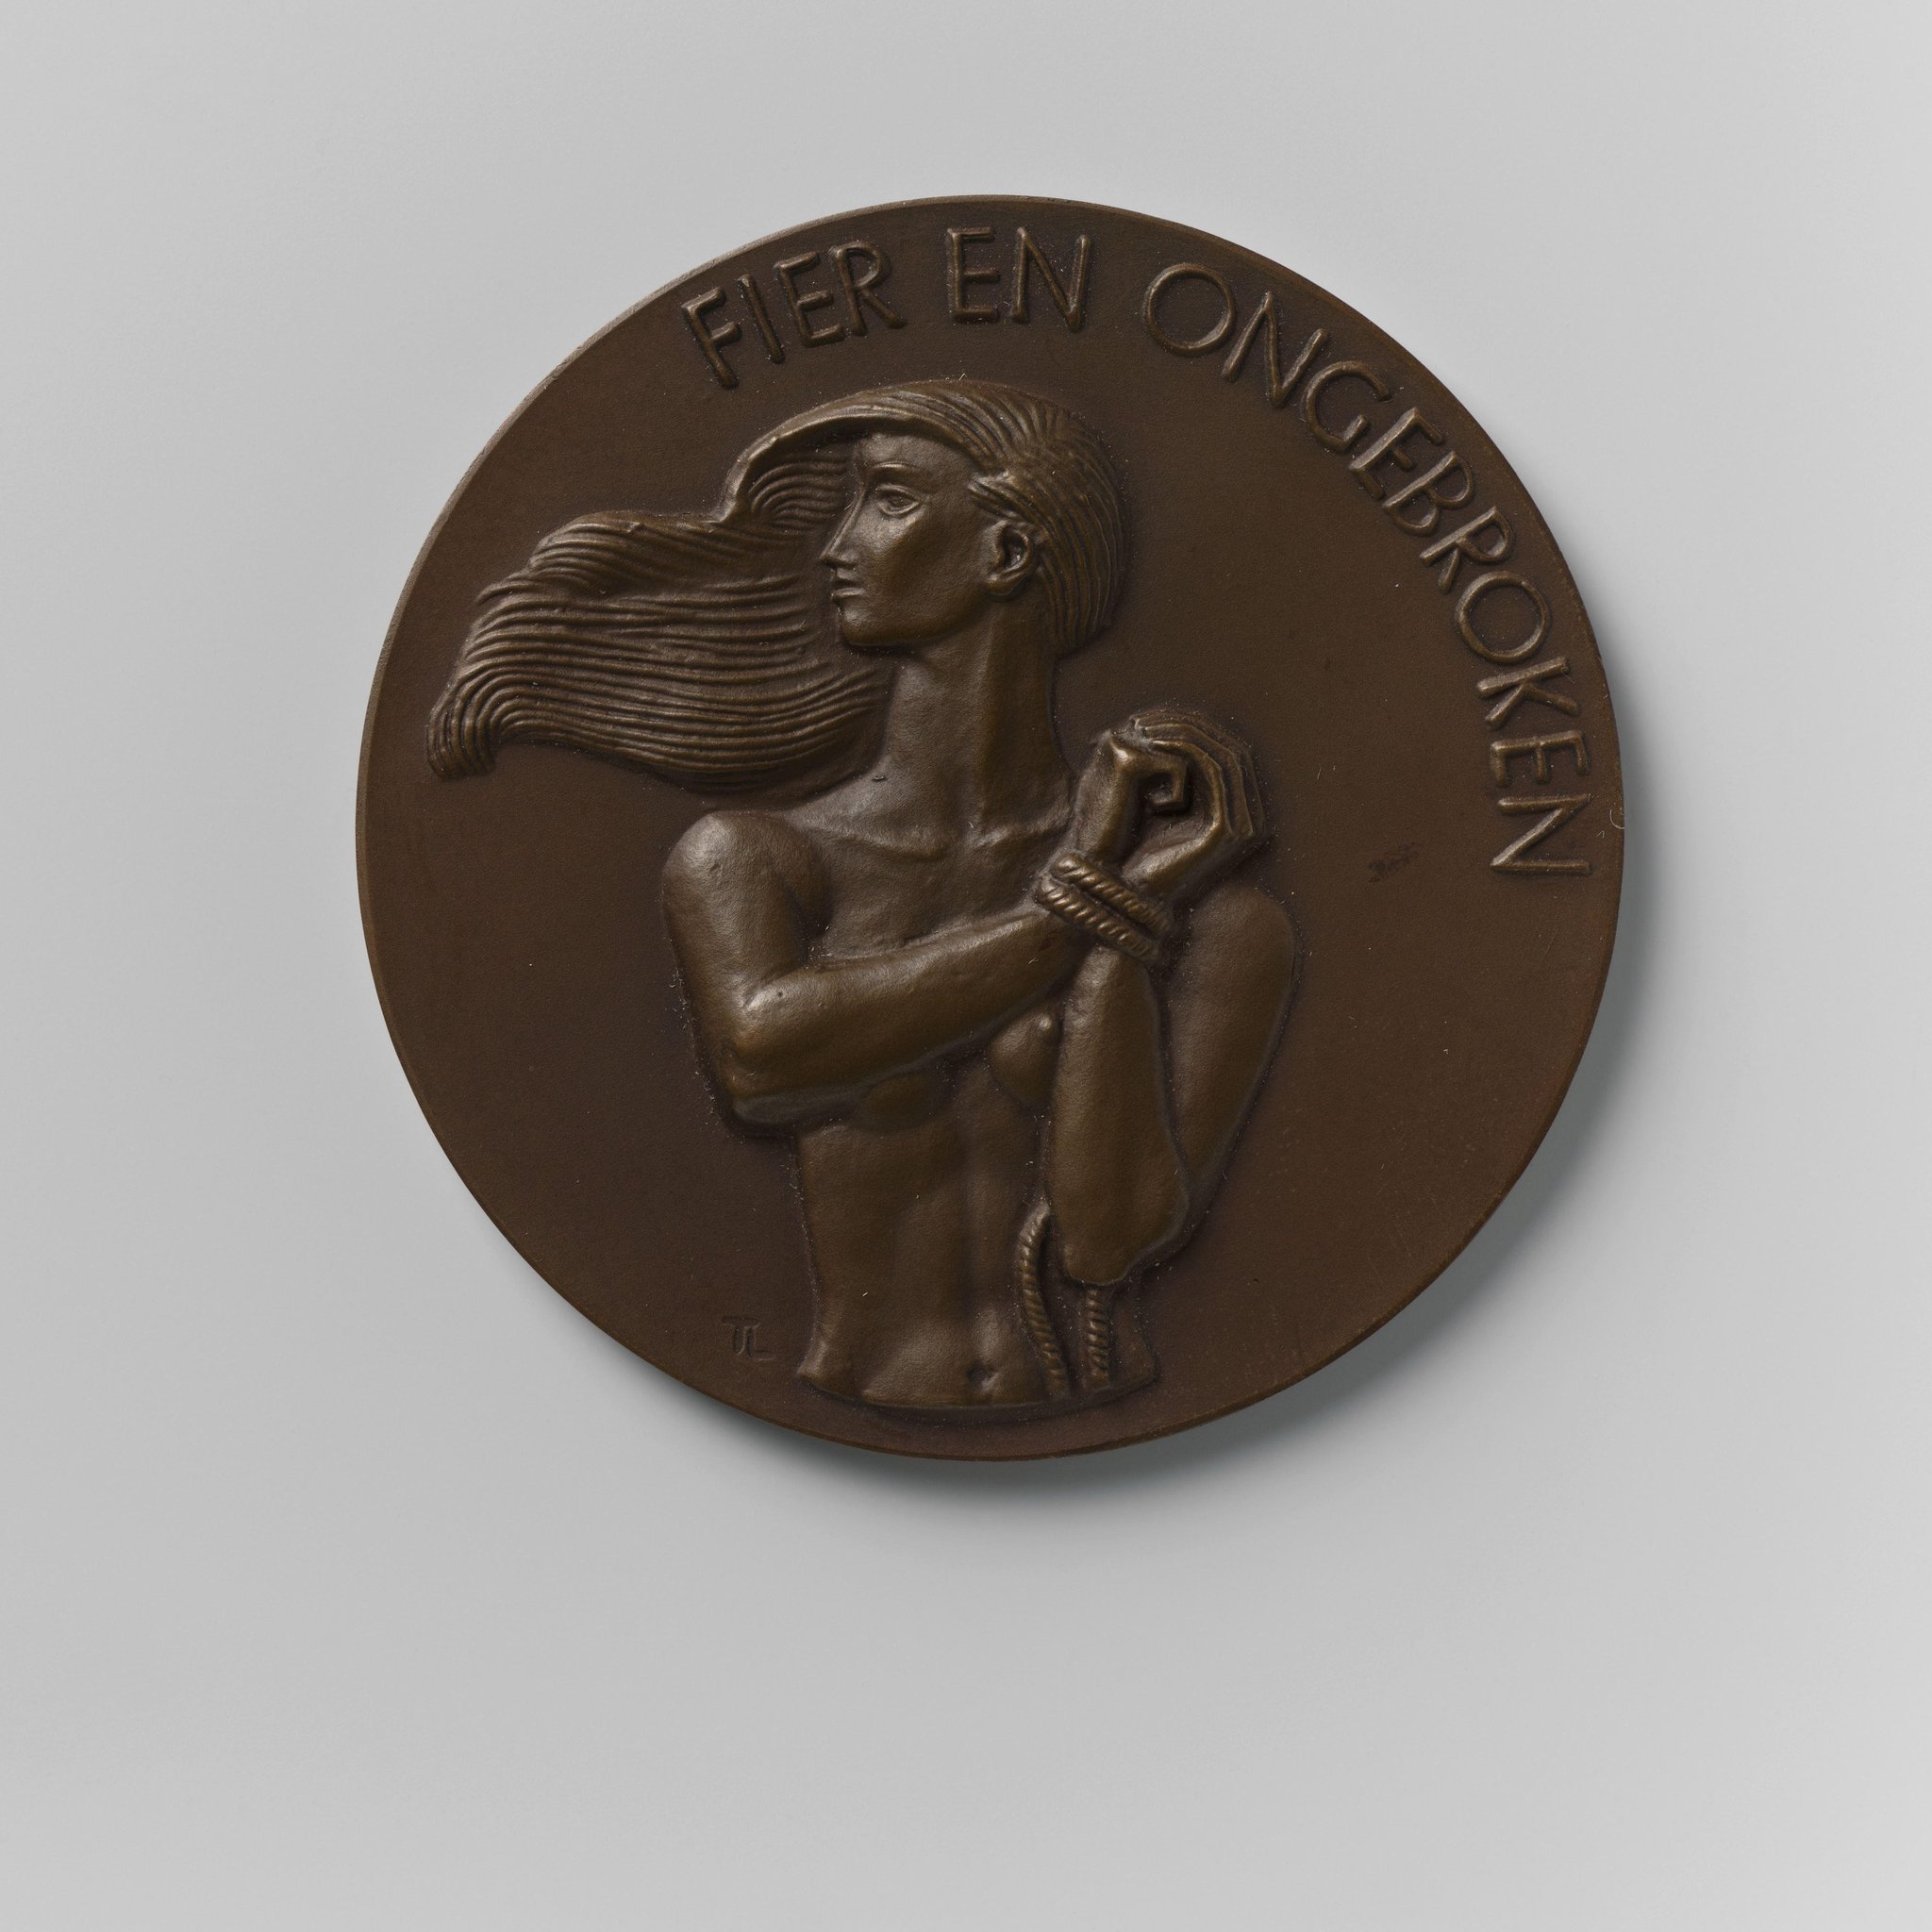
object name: history medal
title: Nederlandse vrouwen in Japanse Vrouwenkampen (Vereniging voor Penningkunst 1947, tweede penning)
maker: titus leeser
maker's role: draughtsman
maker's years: 1903-1996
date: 1947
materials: bronze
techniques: striking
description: Bronzen penning, op de voorzijde een geboeide vrouw met wapperend haar ten halven lijve, met omschrift, op de keerzijde vijf regels tekst waaronder een hek achter twee palmbomen, met omschrift, met verklaring.